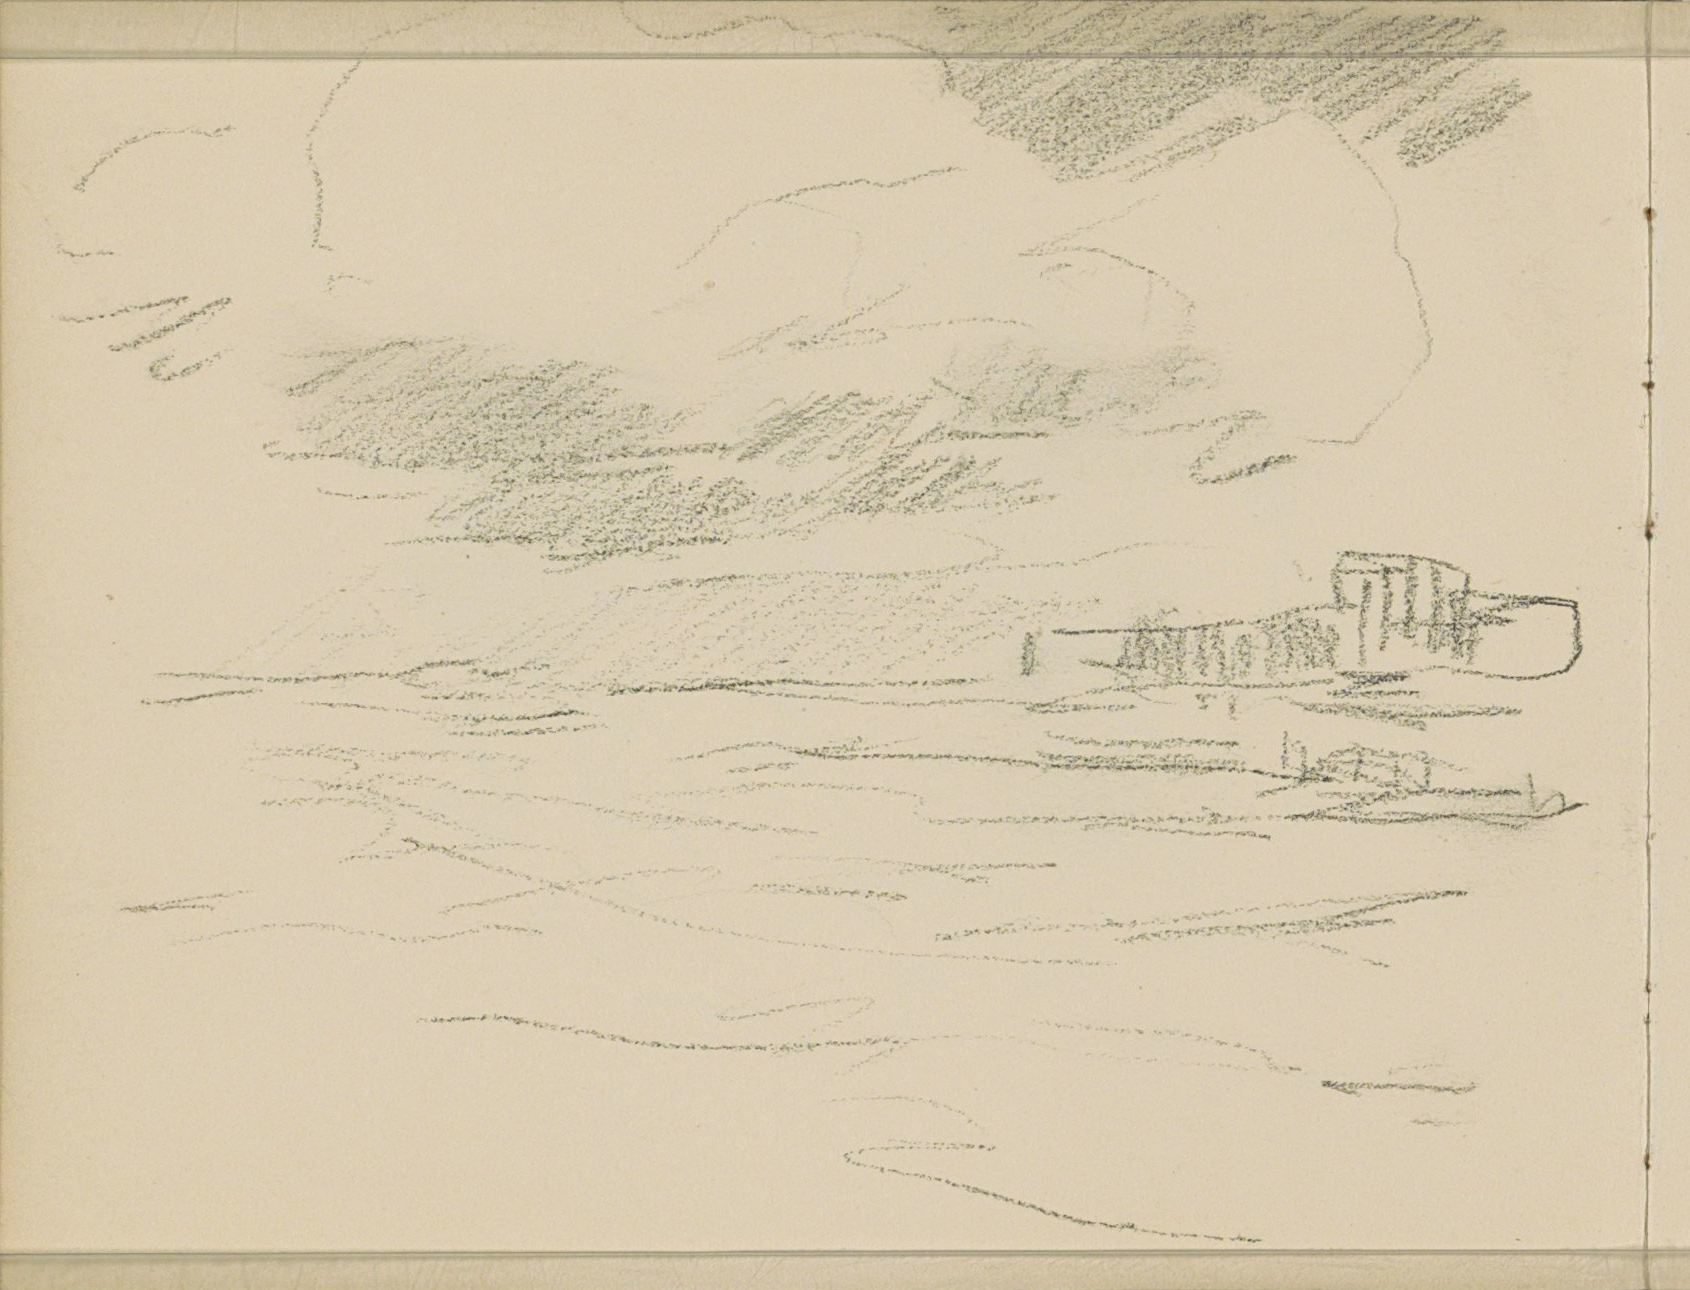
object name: sketchbook leaf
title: Landschap met water, mogelijk de zee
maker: johan antonie de jonge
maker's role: draughtsman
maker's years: 1864-1927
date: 1881-1927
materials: chalk, paper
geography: south holland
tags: landscapes with waters, waterscapes, seascapes (in the temperate zone), sea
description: Landschap met water, mogelijk de zee. Blad 3 verso uit een schetsboek met 34 bladen.